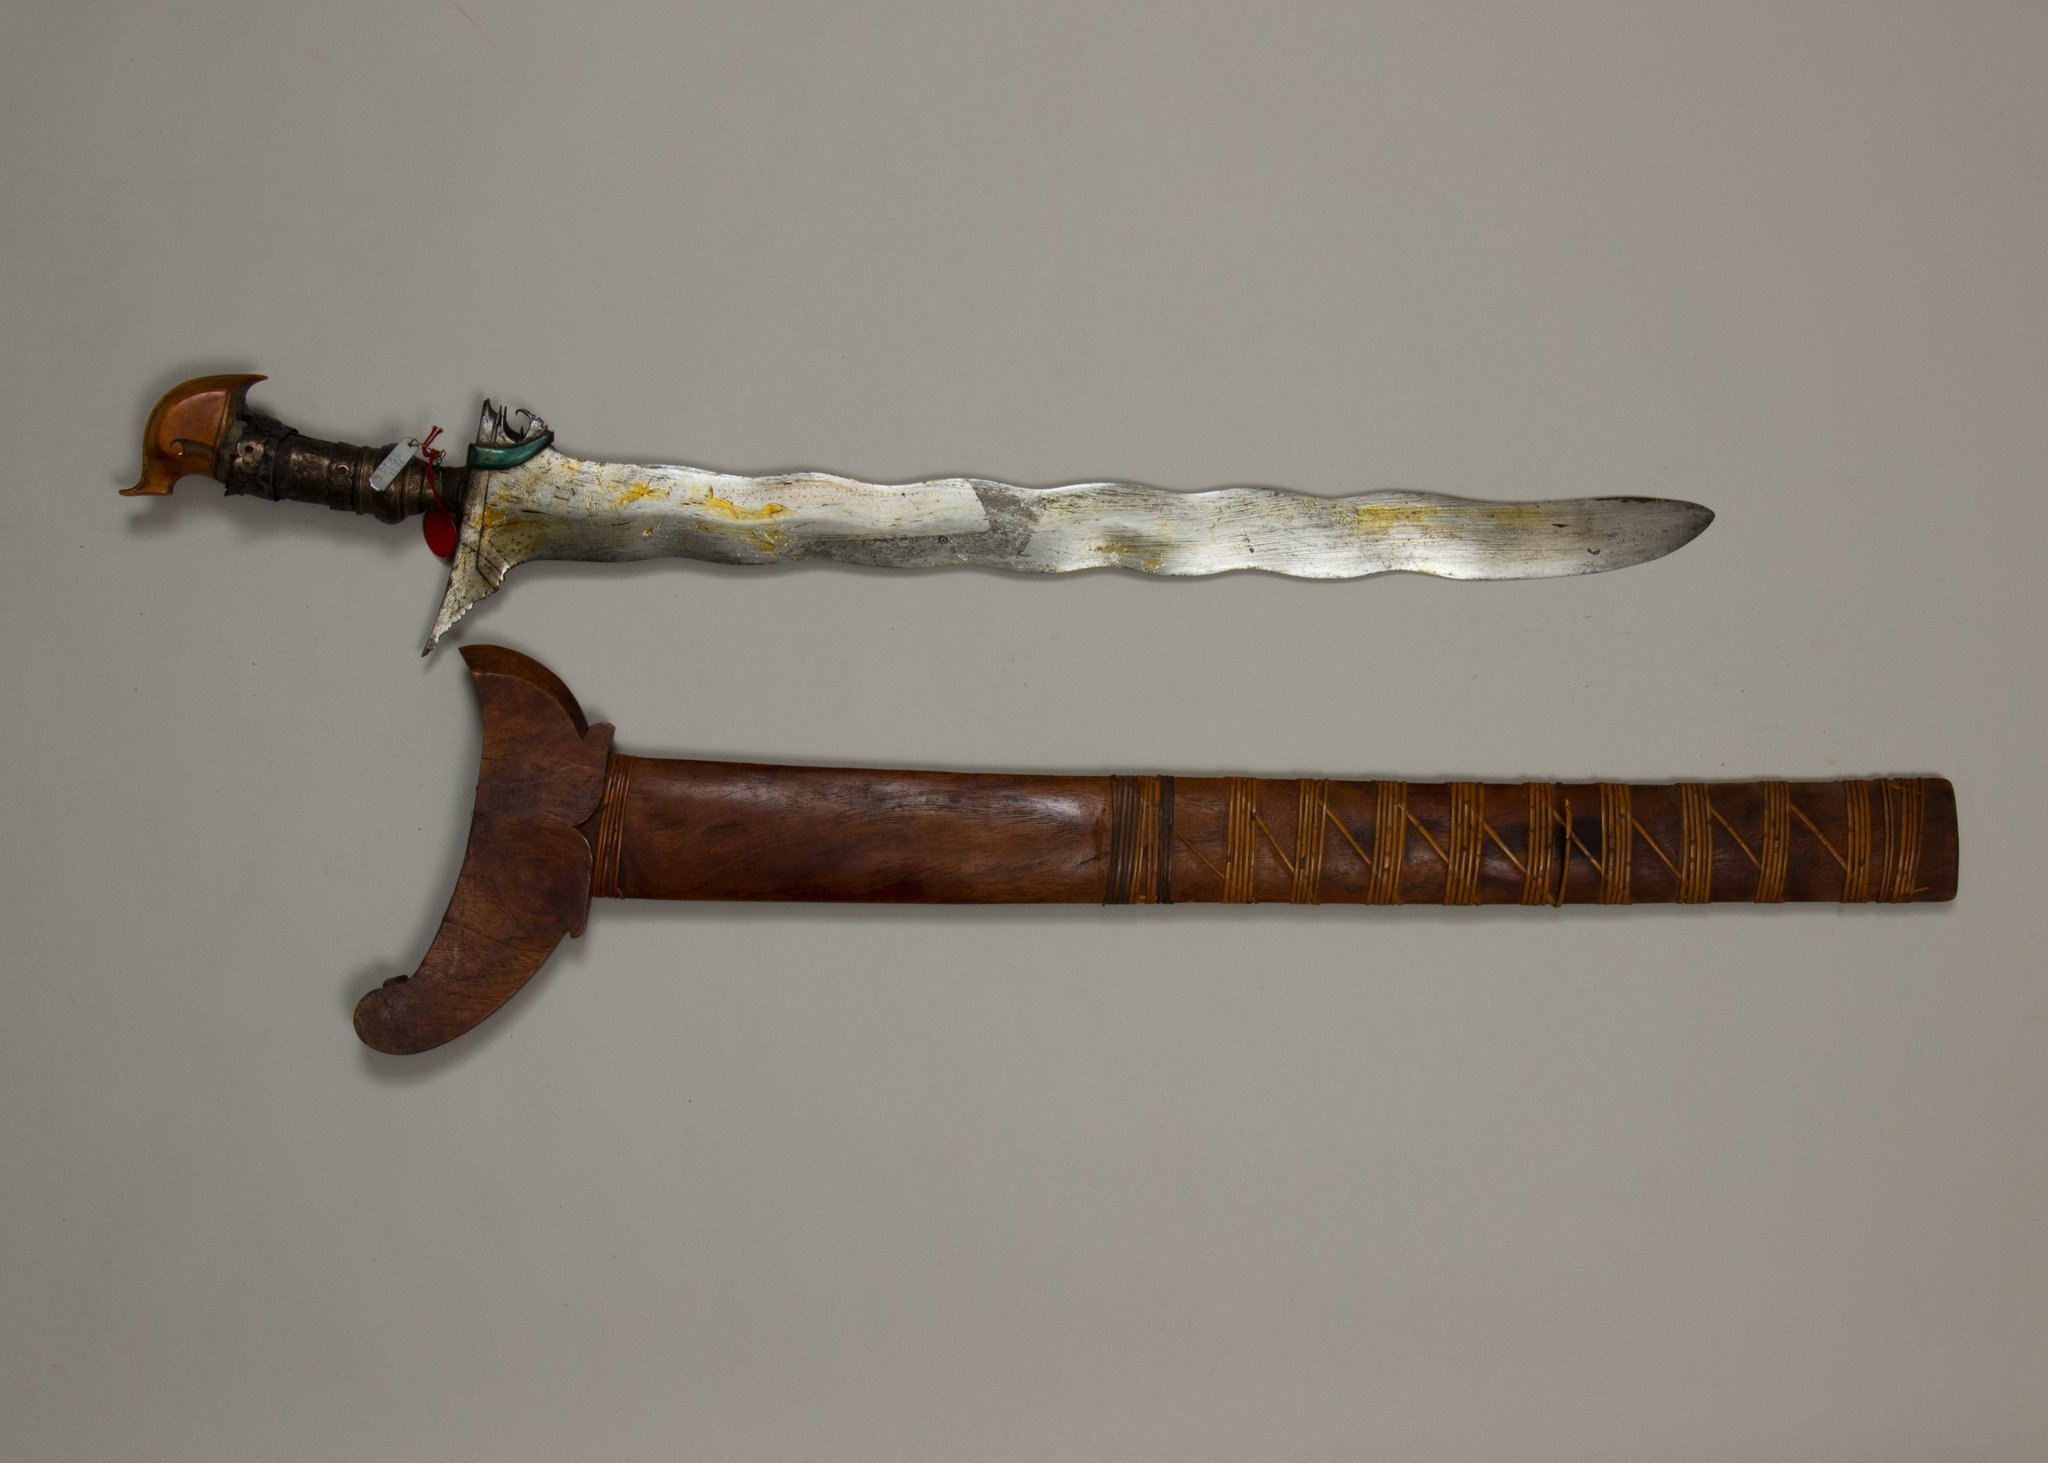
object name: kris with sheath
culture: philippine, sulu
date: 1701-1900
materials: horn, ivory, silver, steel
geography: philippines